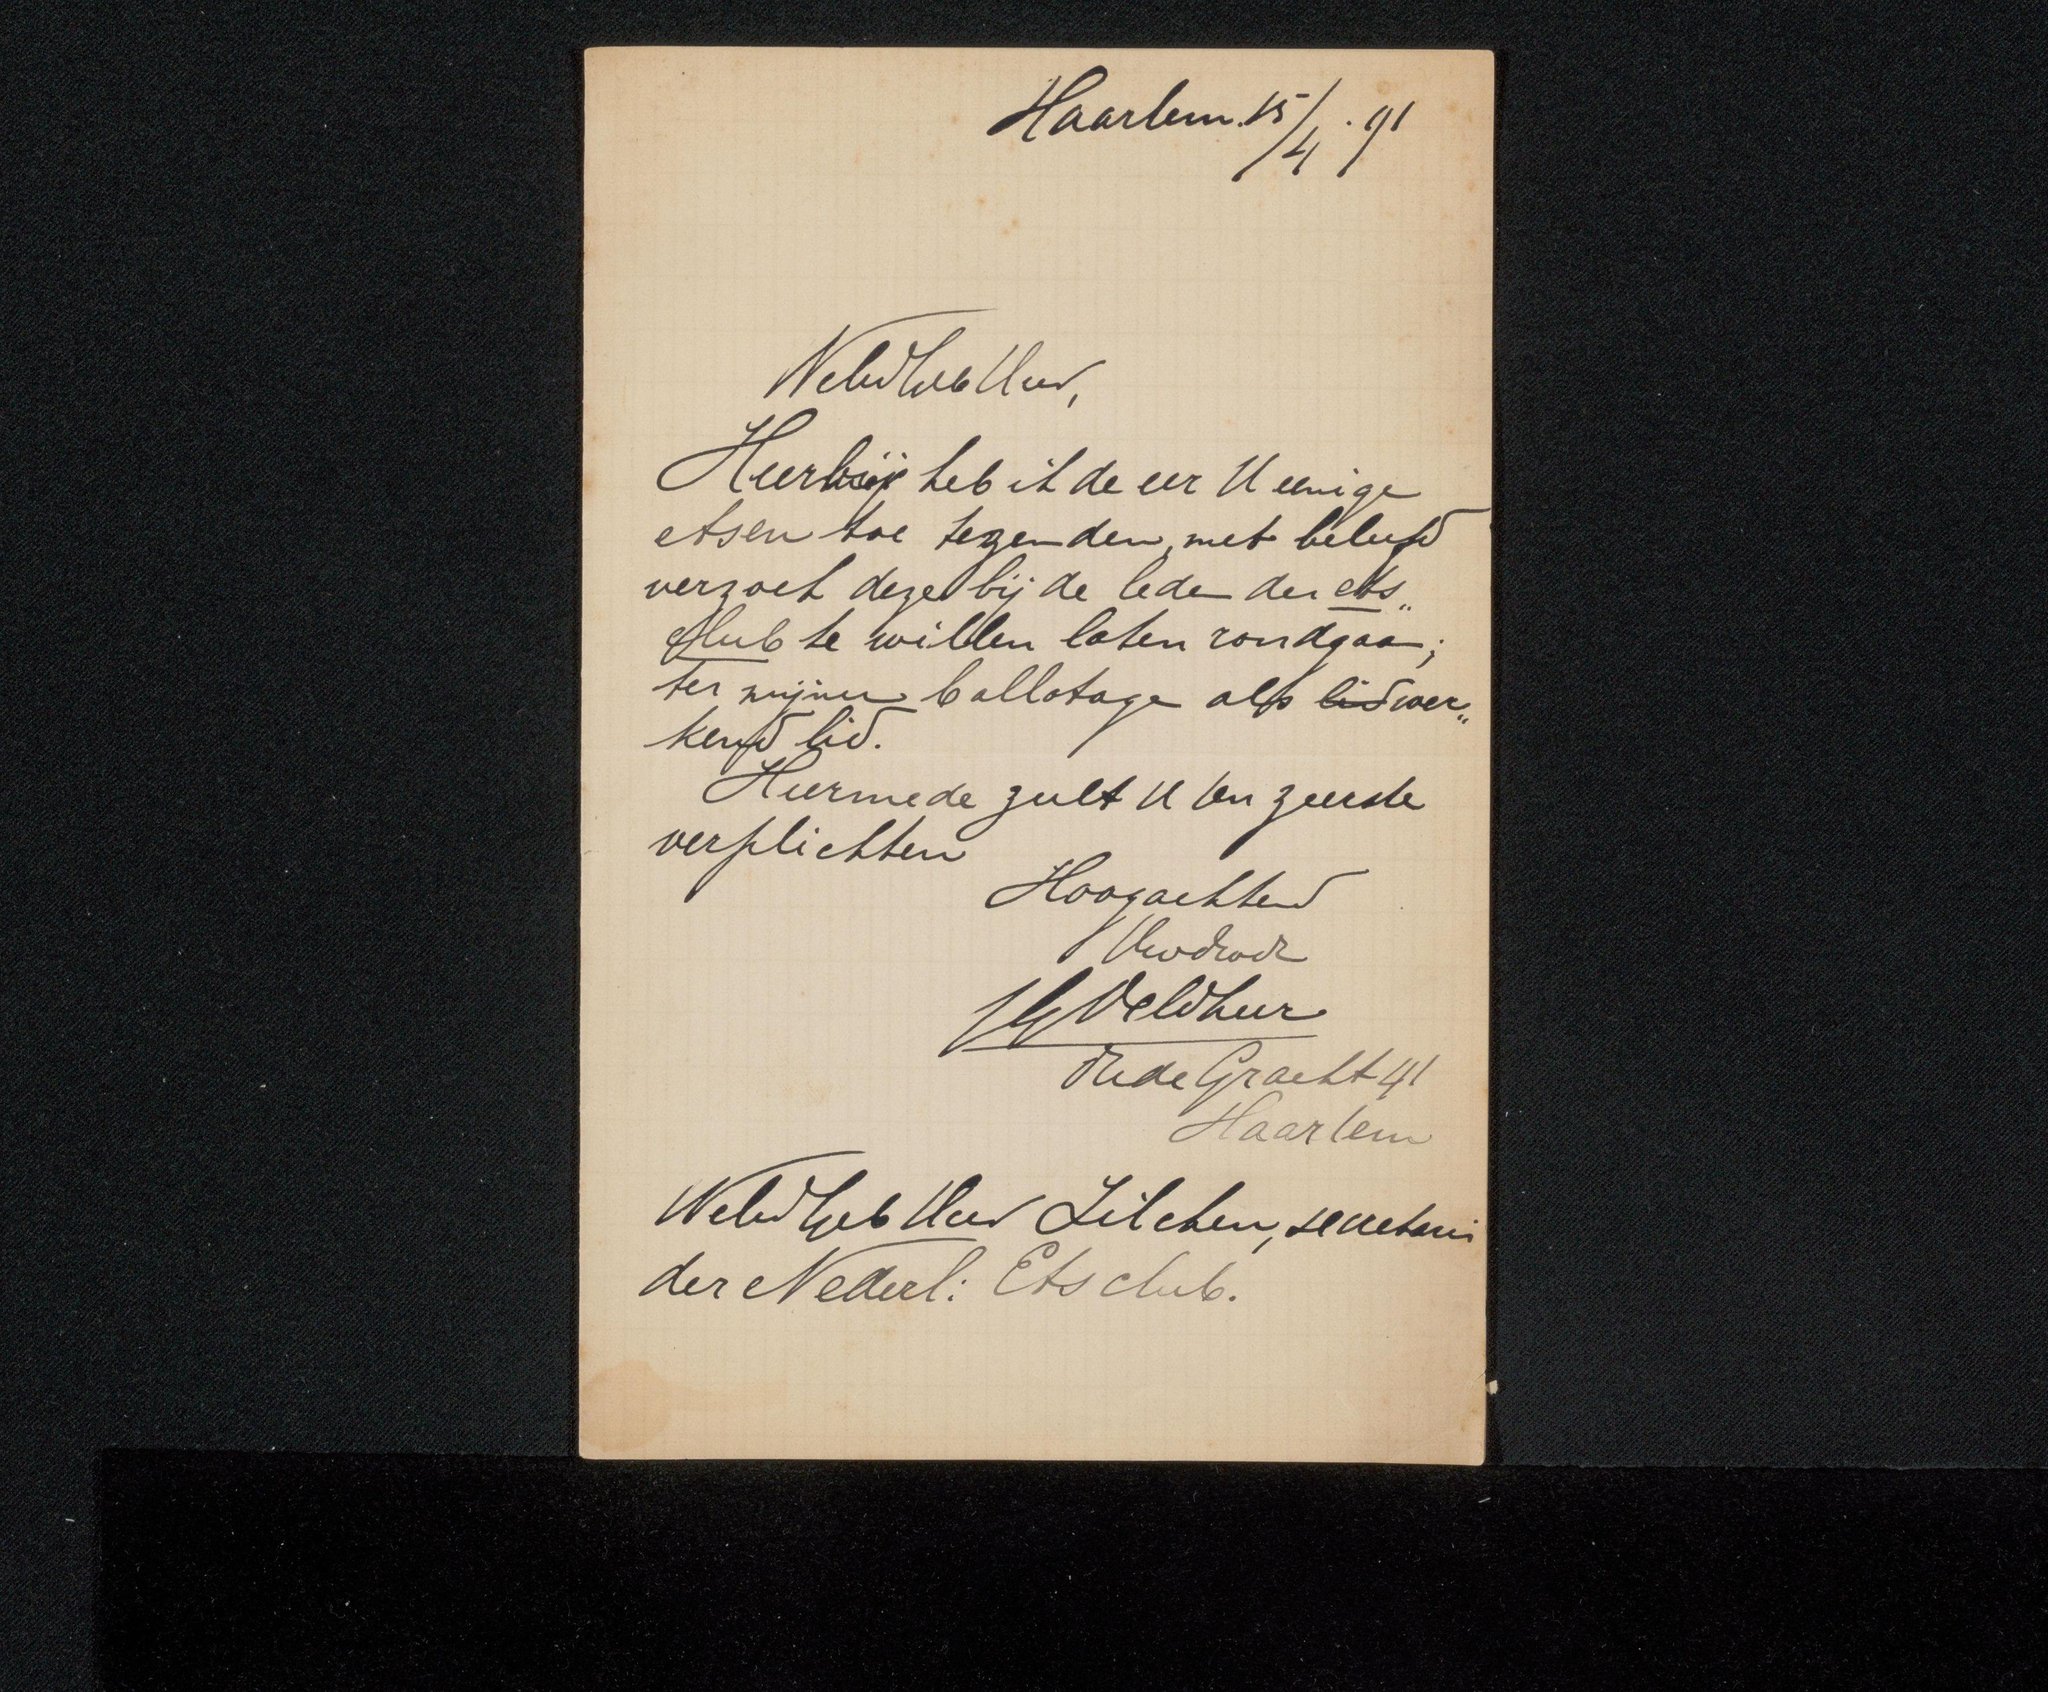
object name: letter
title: Brief aan Philip Zilcken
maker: jacobus gerardus veldheer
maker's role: draughtsman, print maker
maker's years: 1866-1954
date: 1891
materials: ink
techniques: pen, writing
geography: haarlem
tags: the hague, painter, philip zilcken, the graphic arts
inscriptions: collector's mark: ‘RPK’